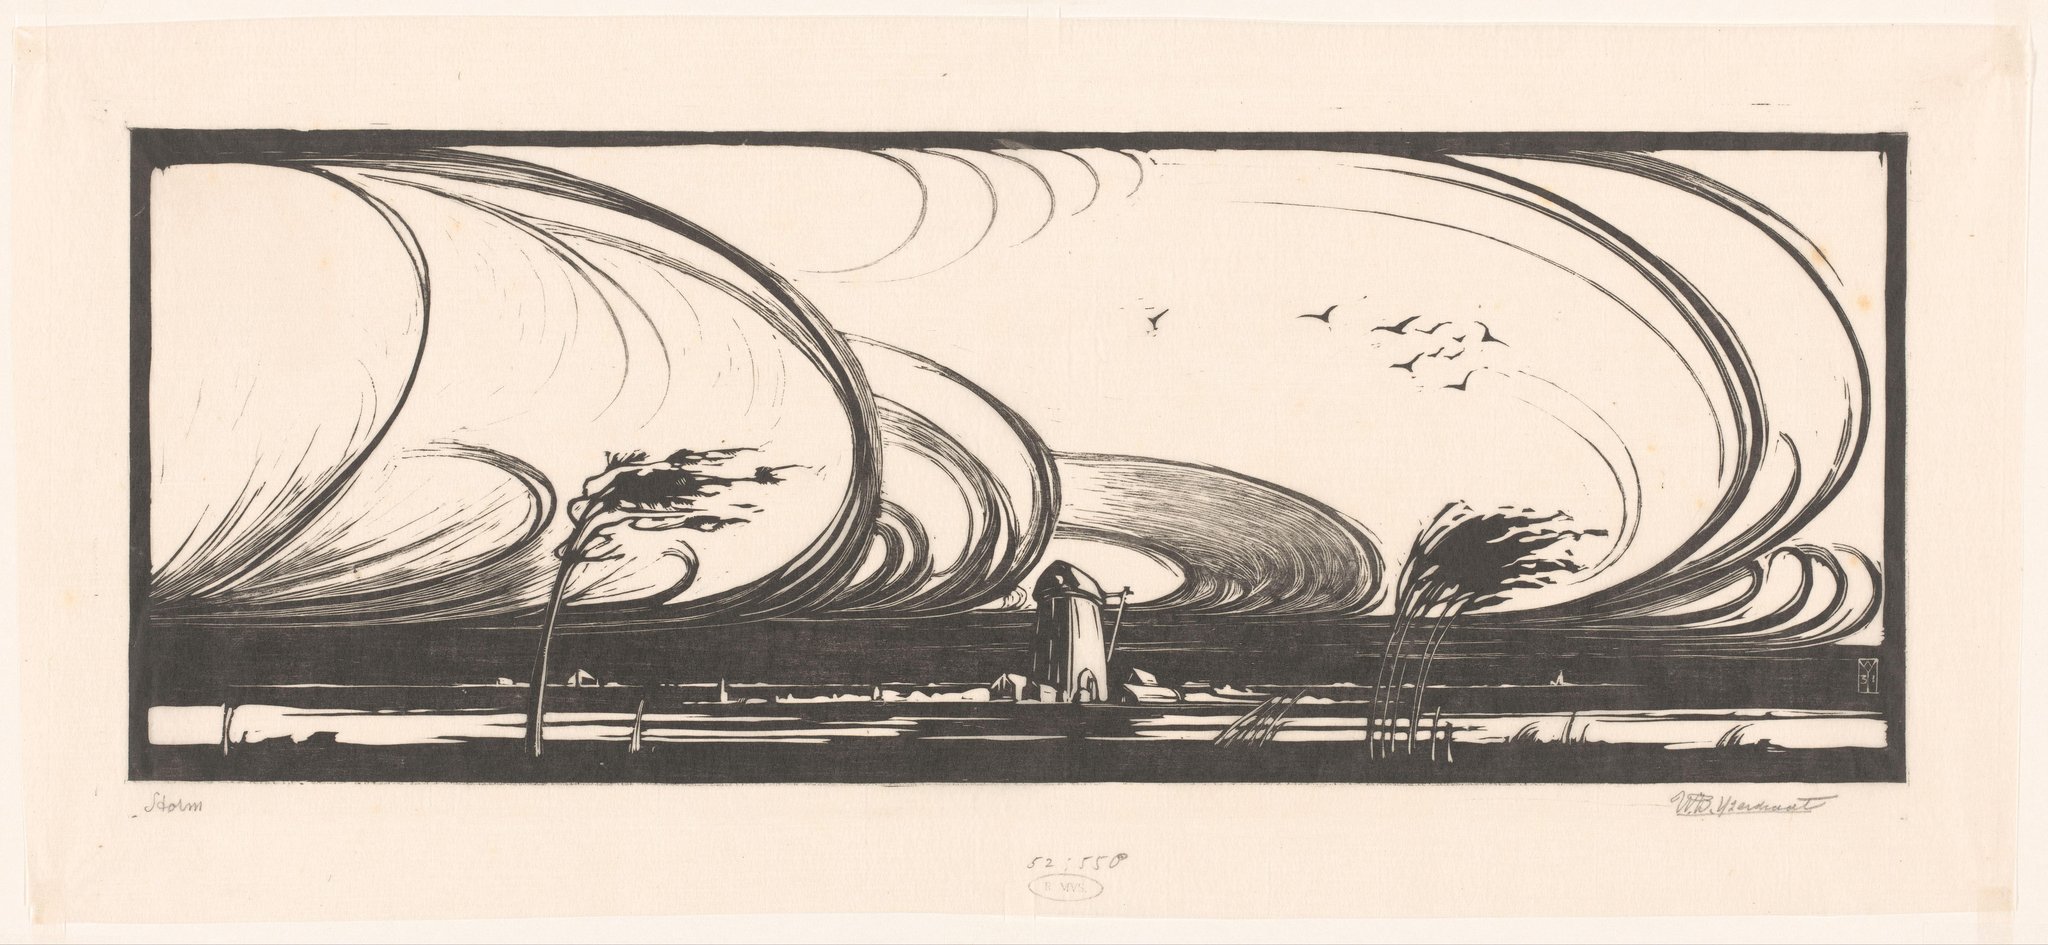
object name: print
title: Storm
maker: willem bernardus ijzerdraat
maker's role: draughtsman, print maker, printer, publisher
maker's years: 1835-1907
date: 1850-1907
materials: paper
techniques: woodcut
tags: landscapes, storm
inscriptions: collector's mark: Lugt 2228